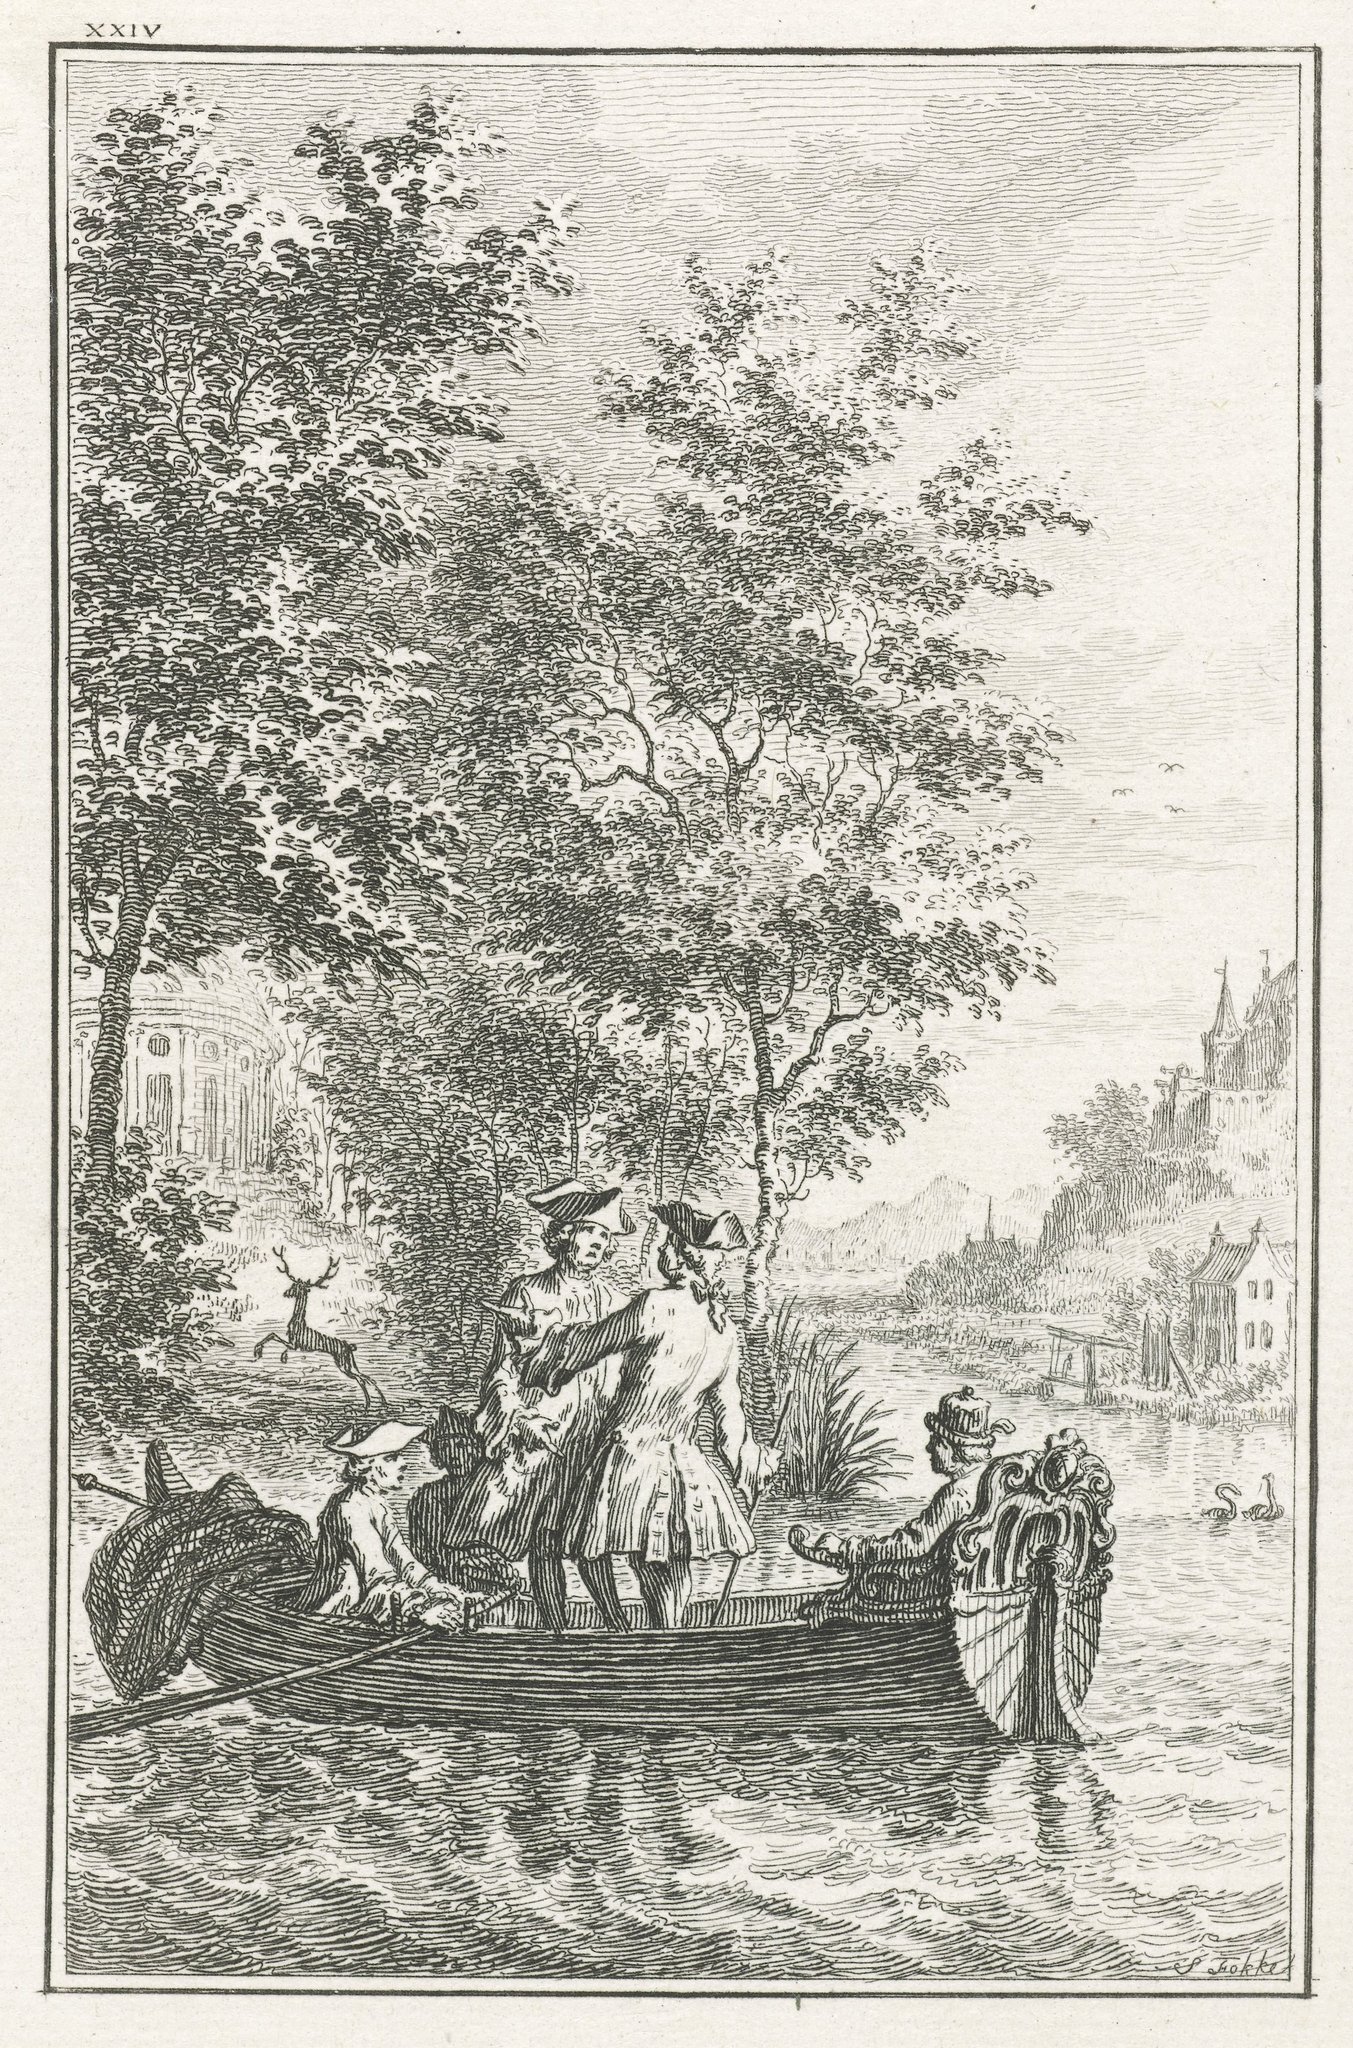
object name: print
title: Vijf heren op een roeiboot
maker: simon fokke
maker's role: draughtsman, print maker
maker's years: 1712-1784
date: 1722-1784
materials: paper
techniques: etching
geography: amsterdam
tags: rowing-boat, canoe, etc.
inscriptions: collector's mark: Lugt 2228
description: Vijf heren bevinden zich op een roeiboot. Twee voeren staand in het midden van de boot een gesprek. Prent linksboven gemerkt: XXIV.